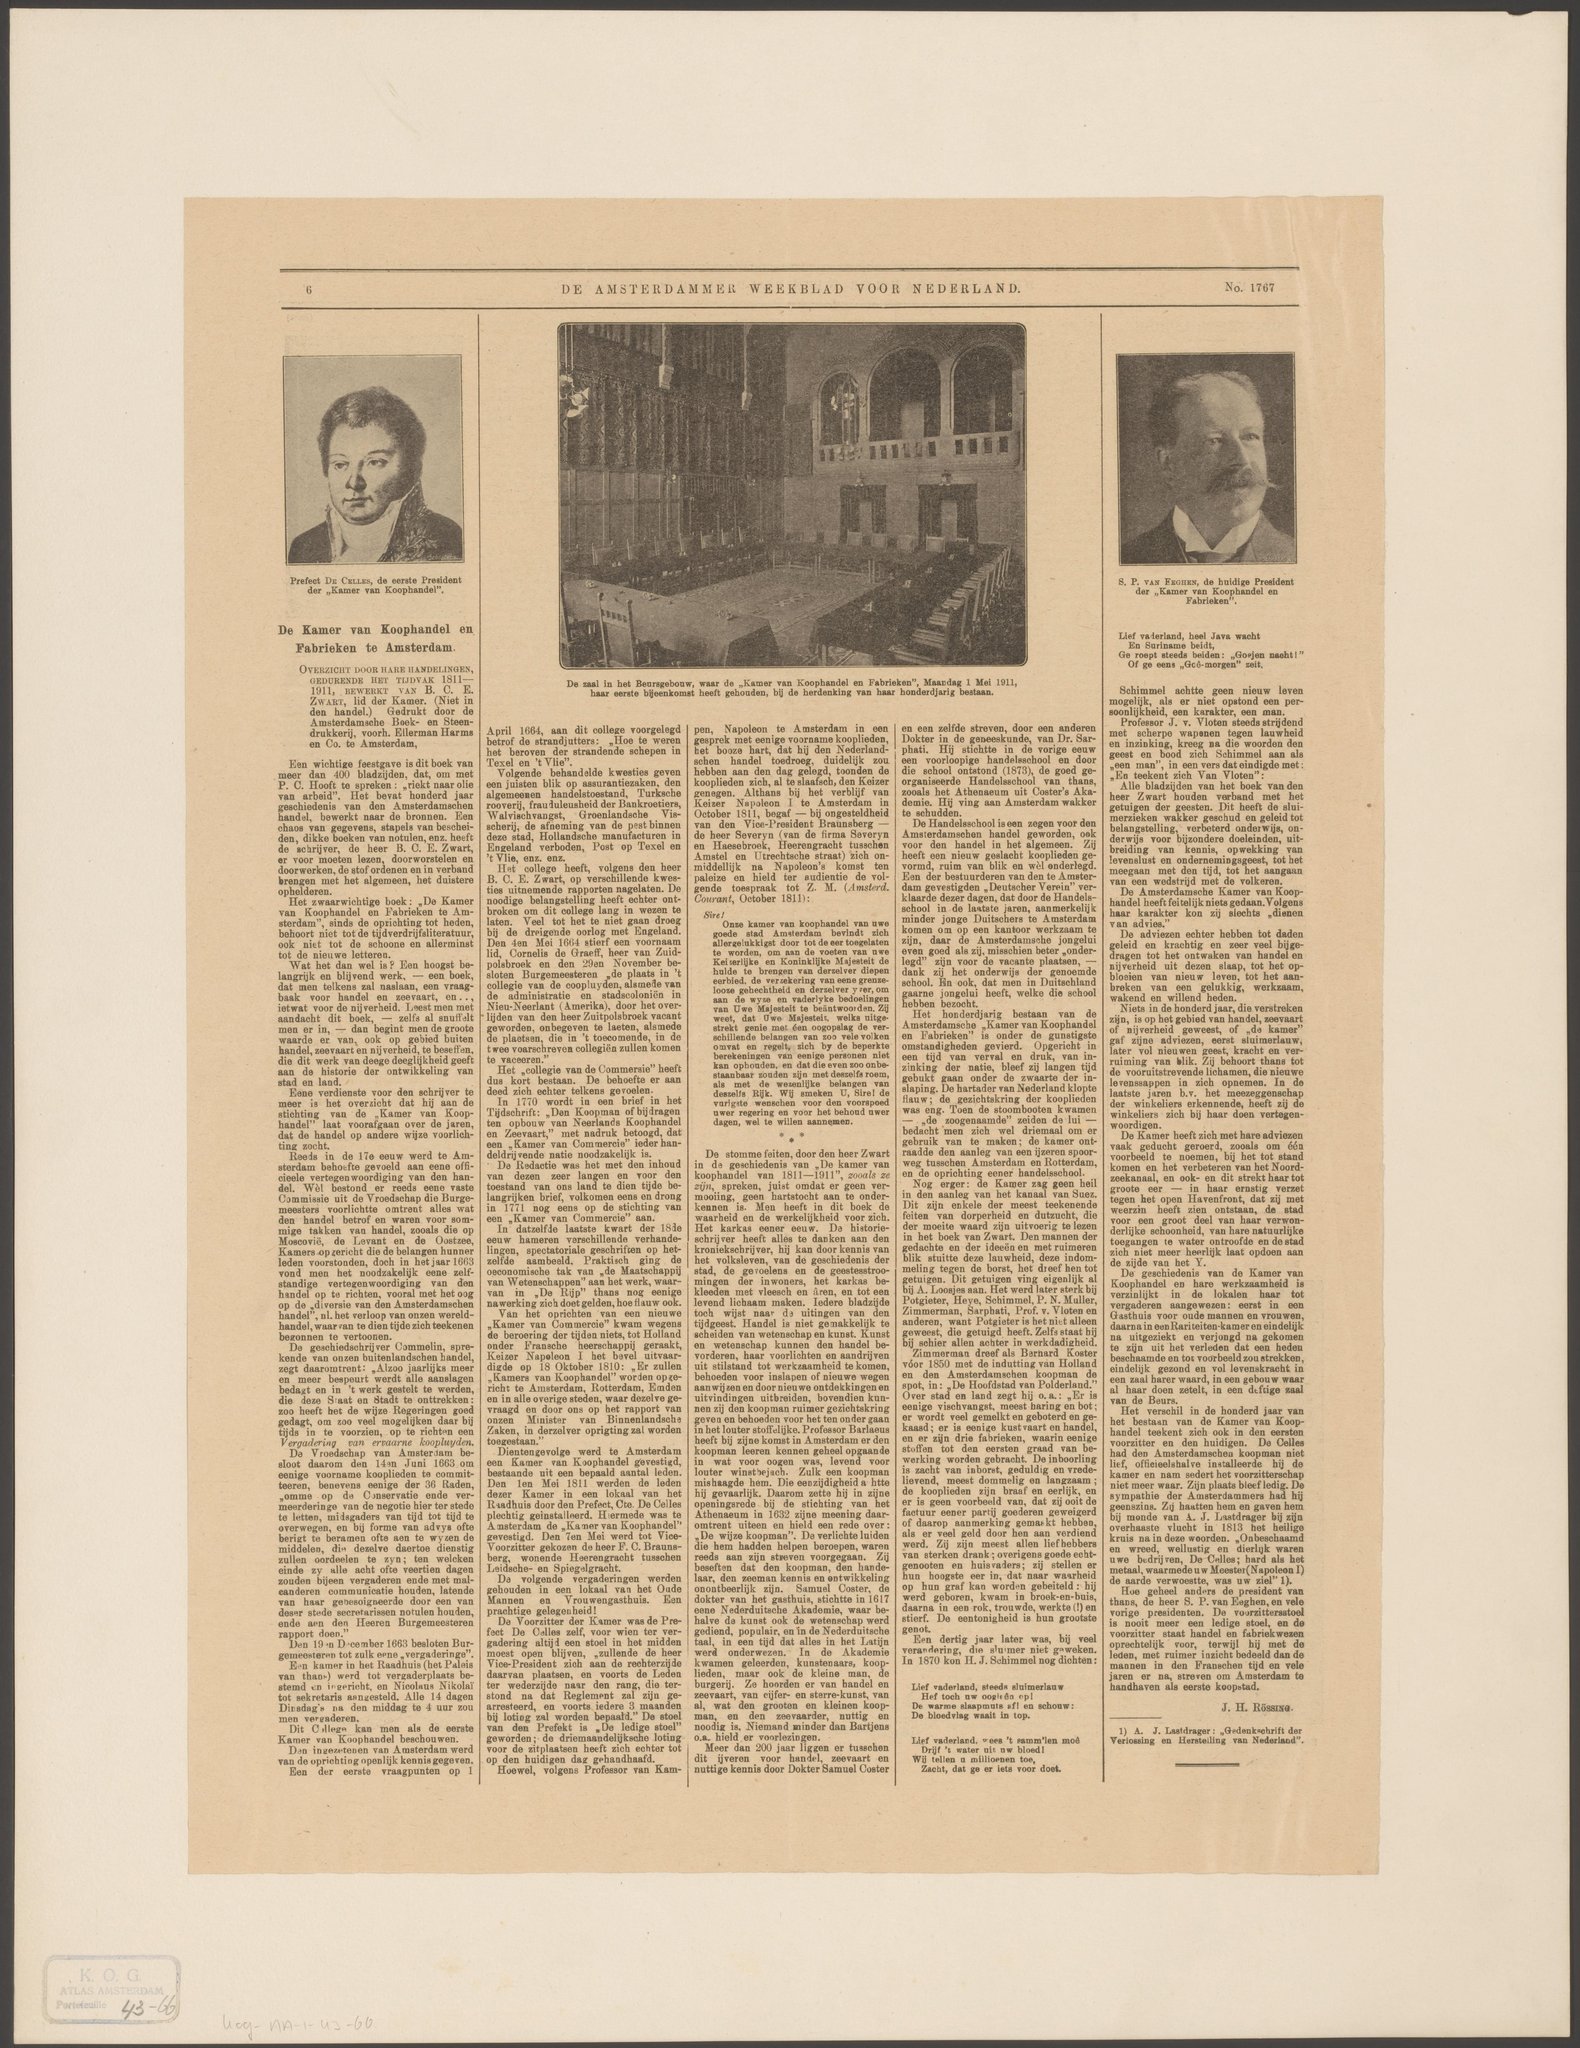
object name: photomechanical print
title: De Kamer van Koophandel en Fabrieken te Amsterdam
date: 1911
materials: paper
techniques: letterpress printing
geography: amsterdam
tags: zeist, politician, chamber of commerce, historical persons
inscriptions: collector's mark: Lugt 1641b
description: Artikel over de Kamer van Koophandel en Fabrieken te Amsterdam, met een portret van Antoine de Celles, het interieur van de Kamer van Koophandel in de Beurs van Berlage en een portret van Sam van Eeghen. Onderwerpsrubriek binnen de Atlas Amsterdam: Markten, handel: Nederlandsche Handelmaatschappij.